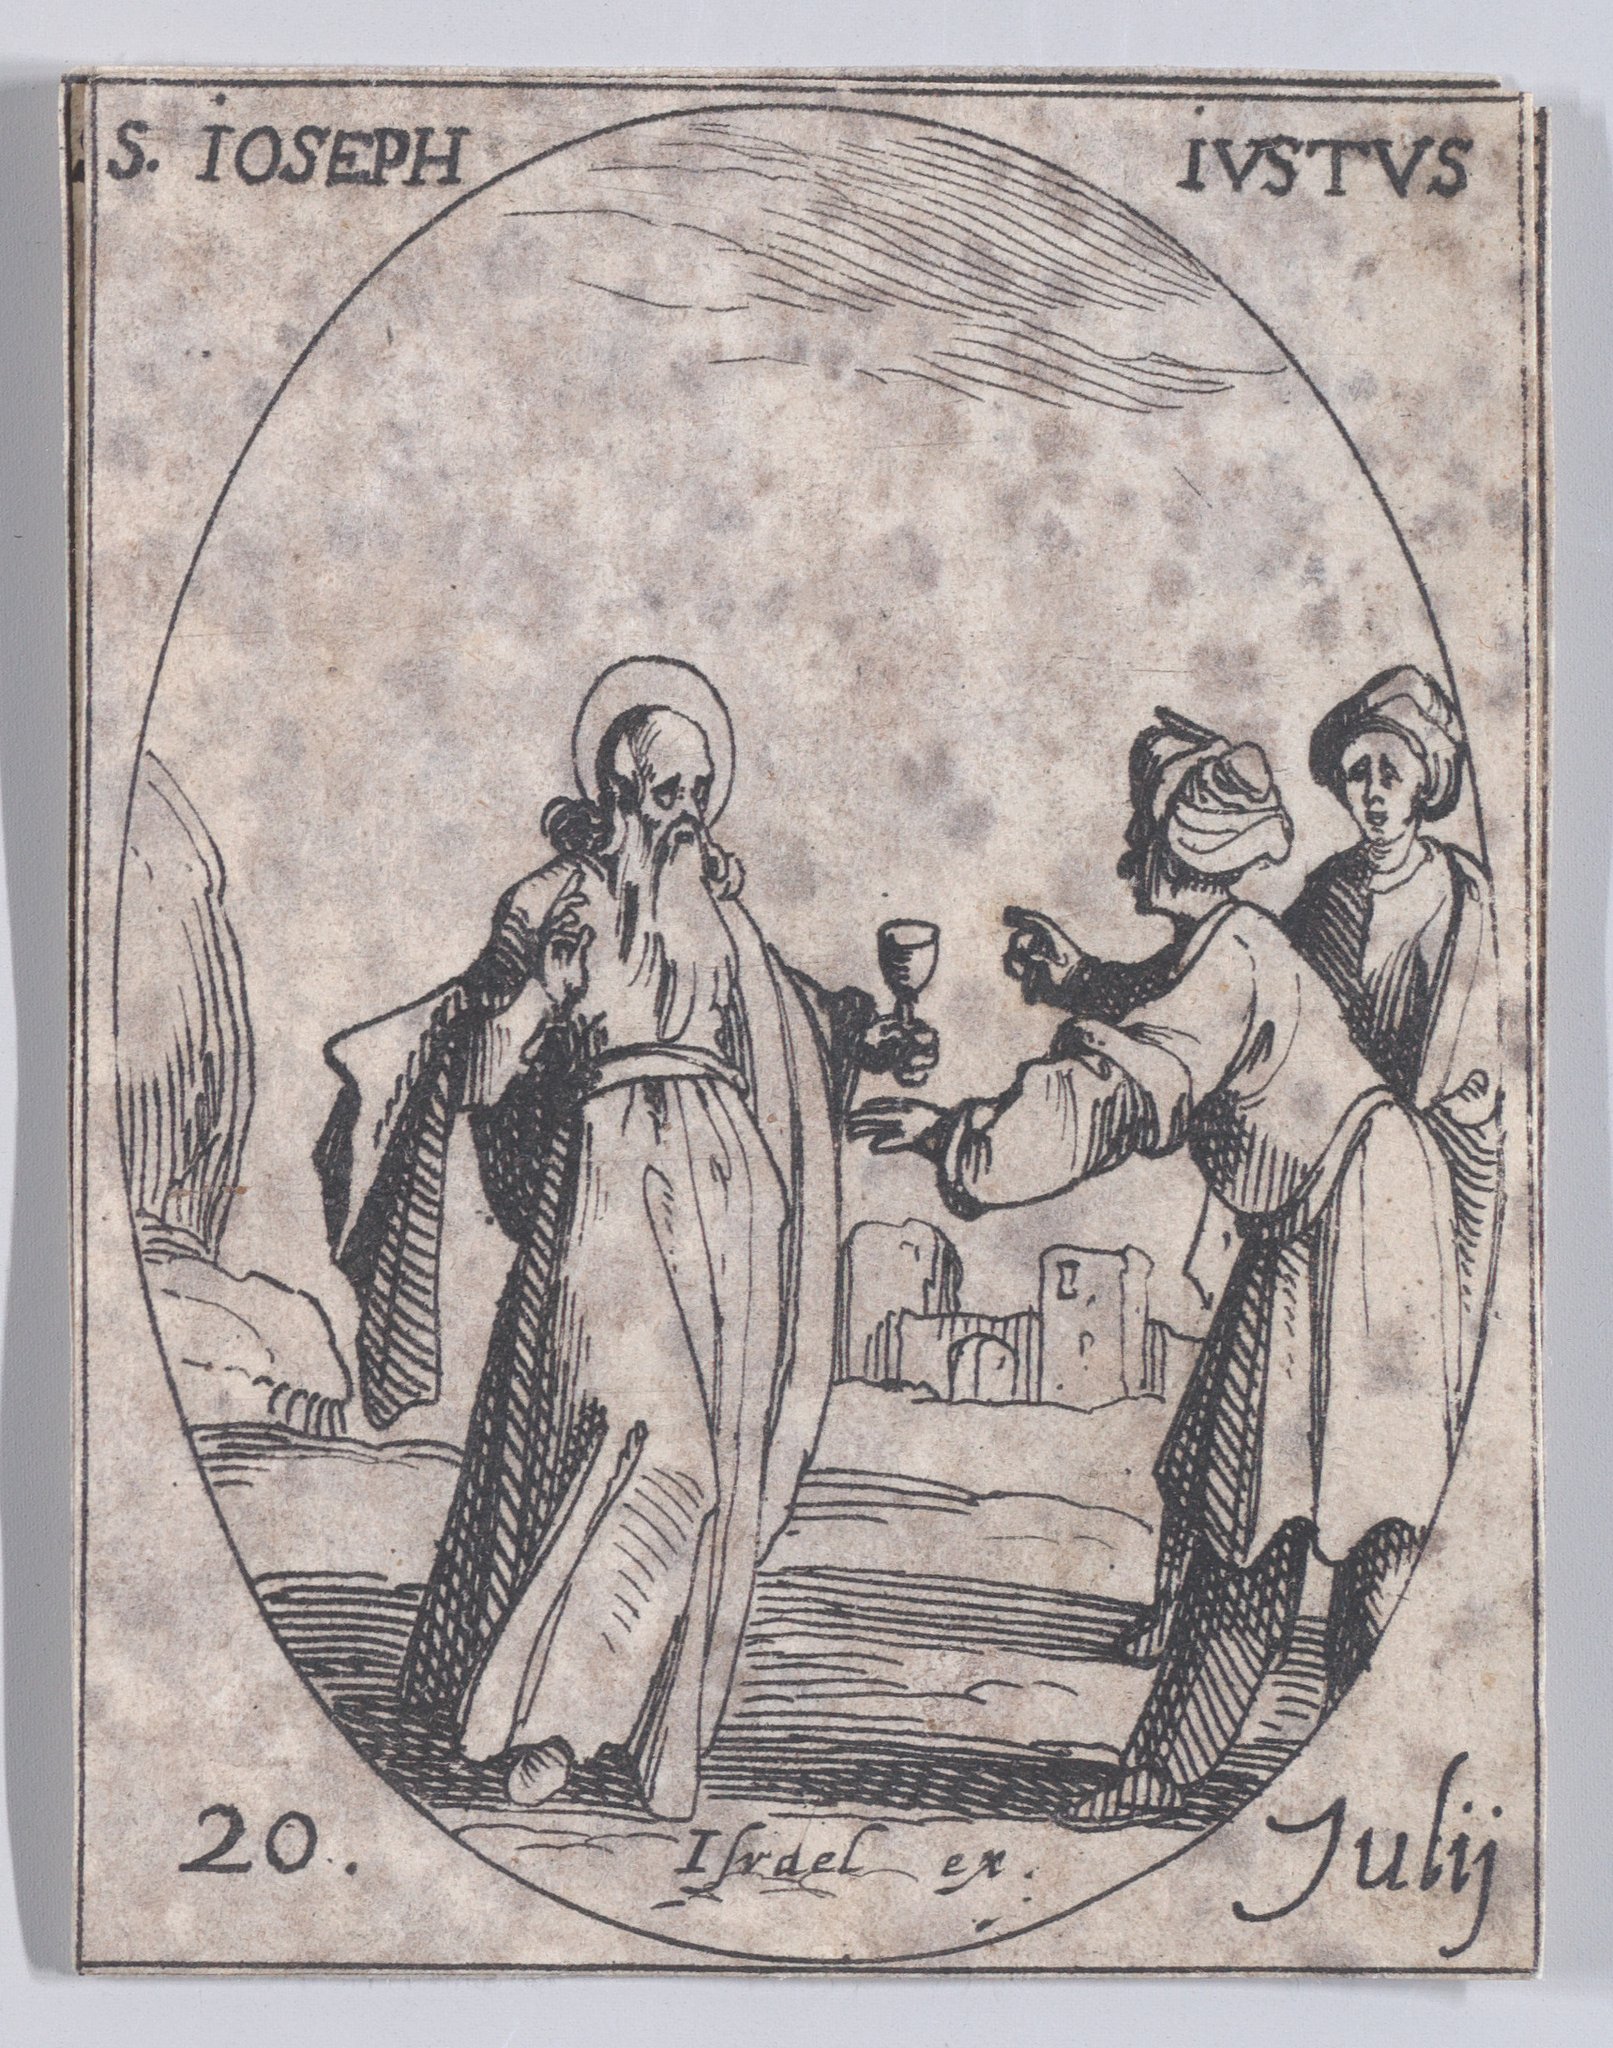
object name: print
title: S. Joseph, le juste (St. Joseph the Just), July 20th, from "Les Images De Tous Les Saincts et Saintes de L'Année" (Images of All of the Saints and Religious Events of the Year)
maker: jacques callot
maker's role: artist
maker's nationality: french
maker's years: 1592-1635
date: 1636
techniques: etching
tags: men,saints